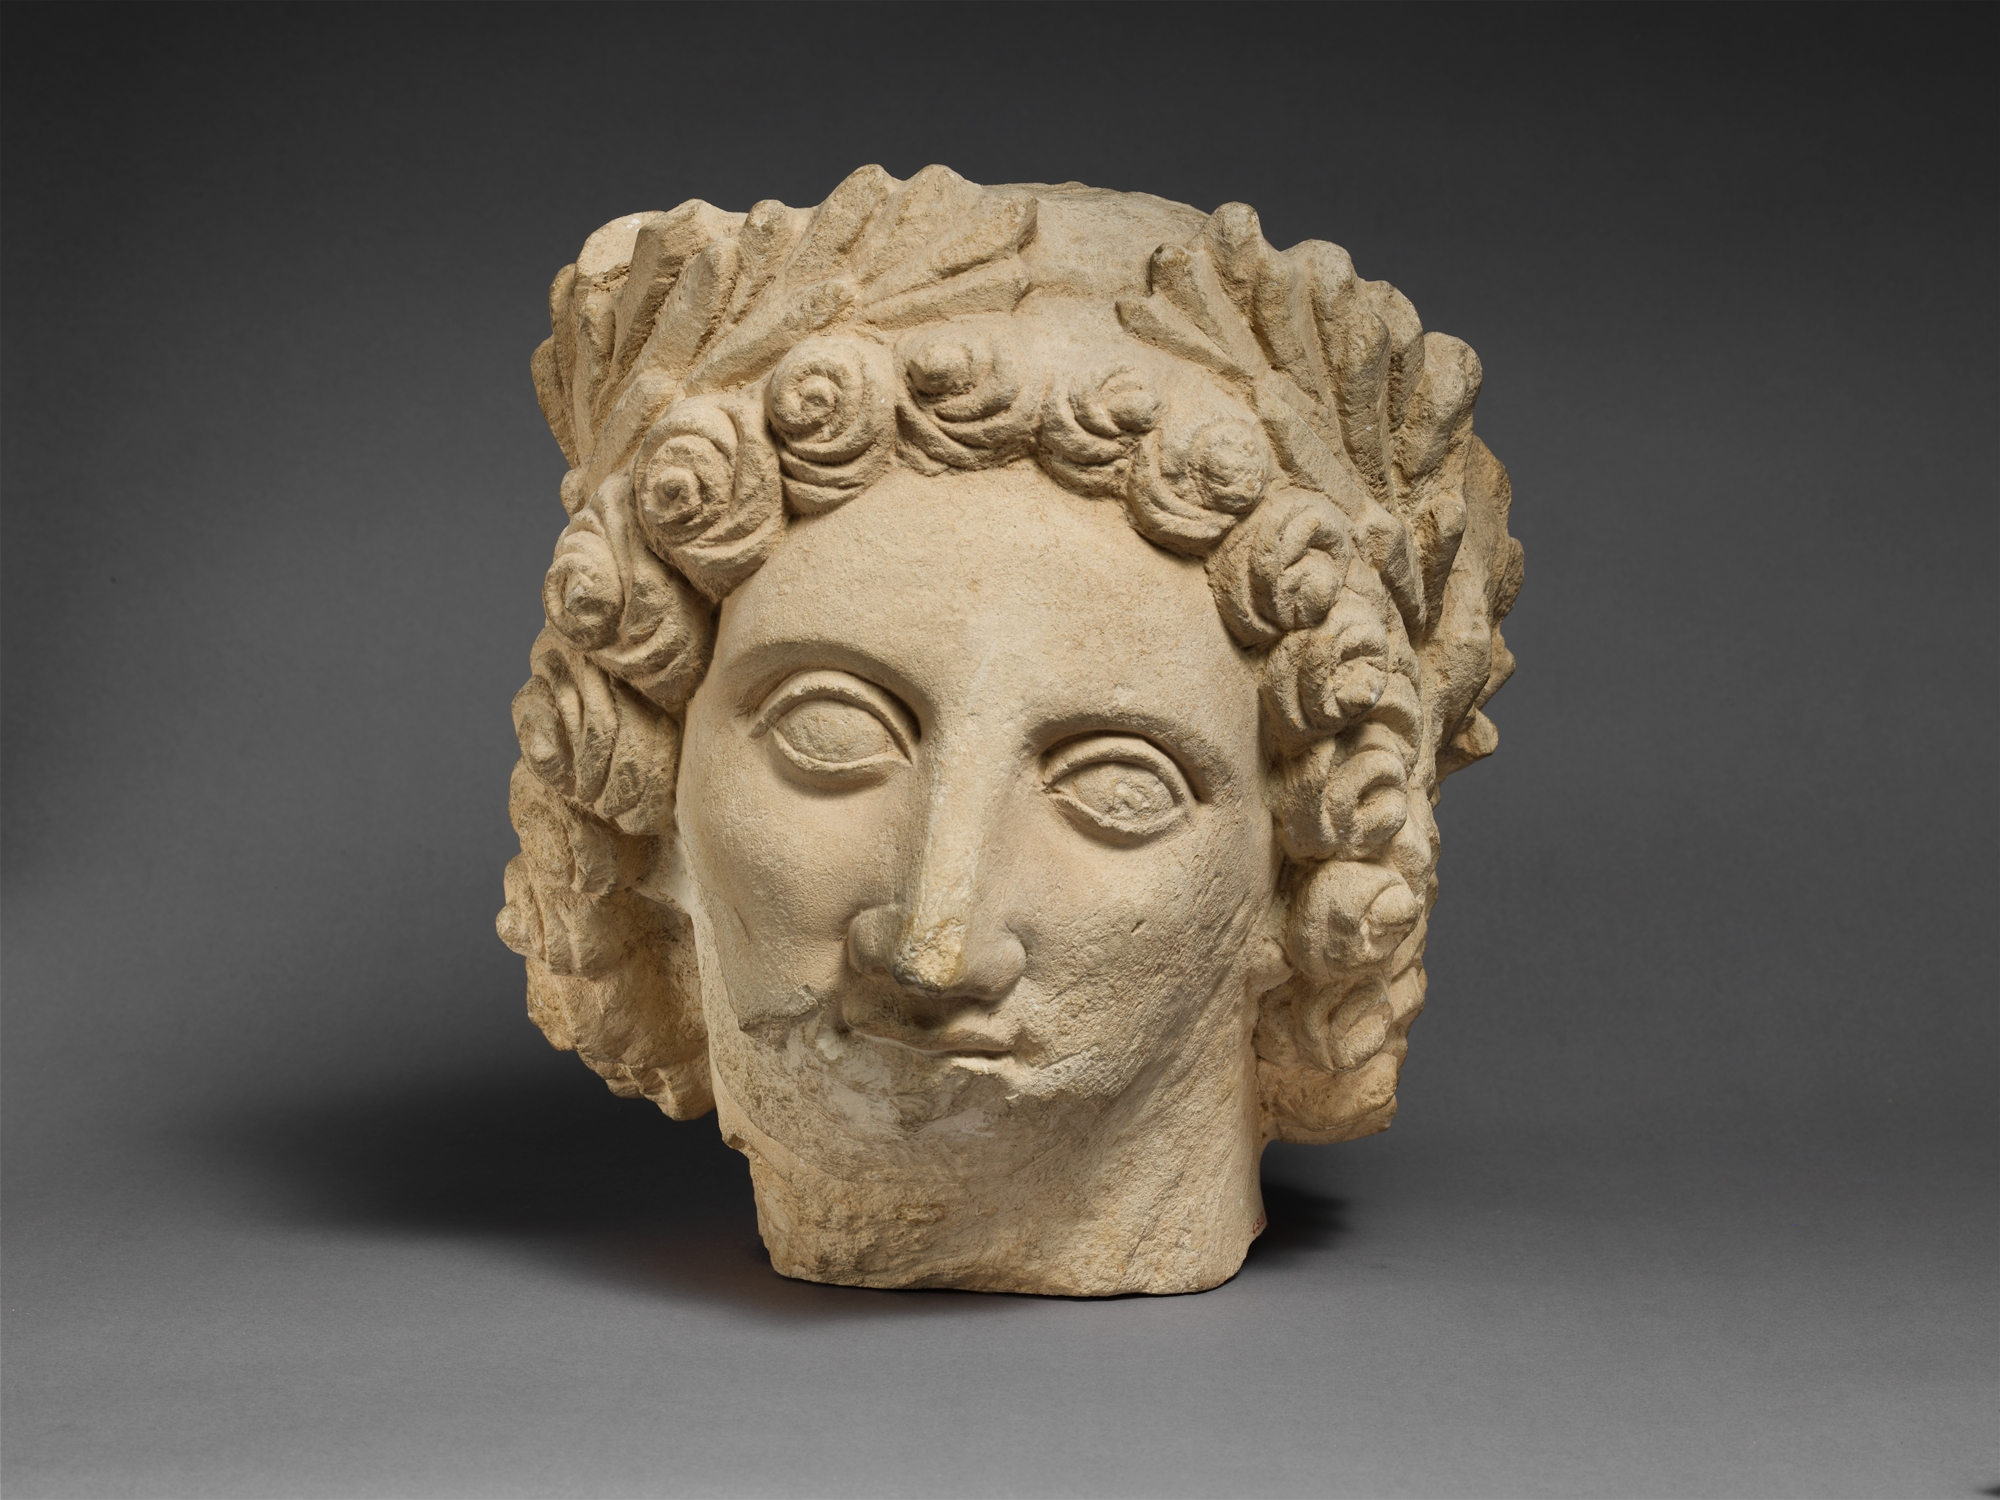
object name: head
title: Limestone head of Apollo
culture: cypriot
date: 3900 BCE-100 CE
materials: limestone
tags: heads,apollo,wreaths